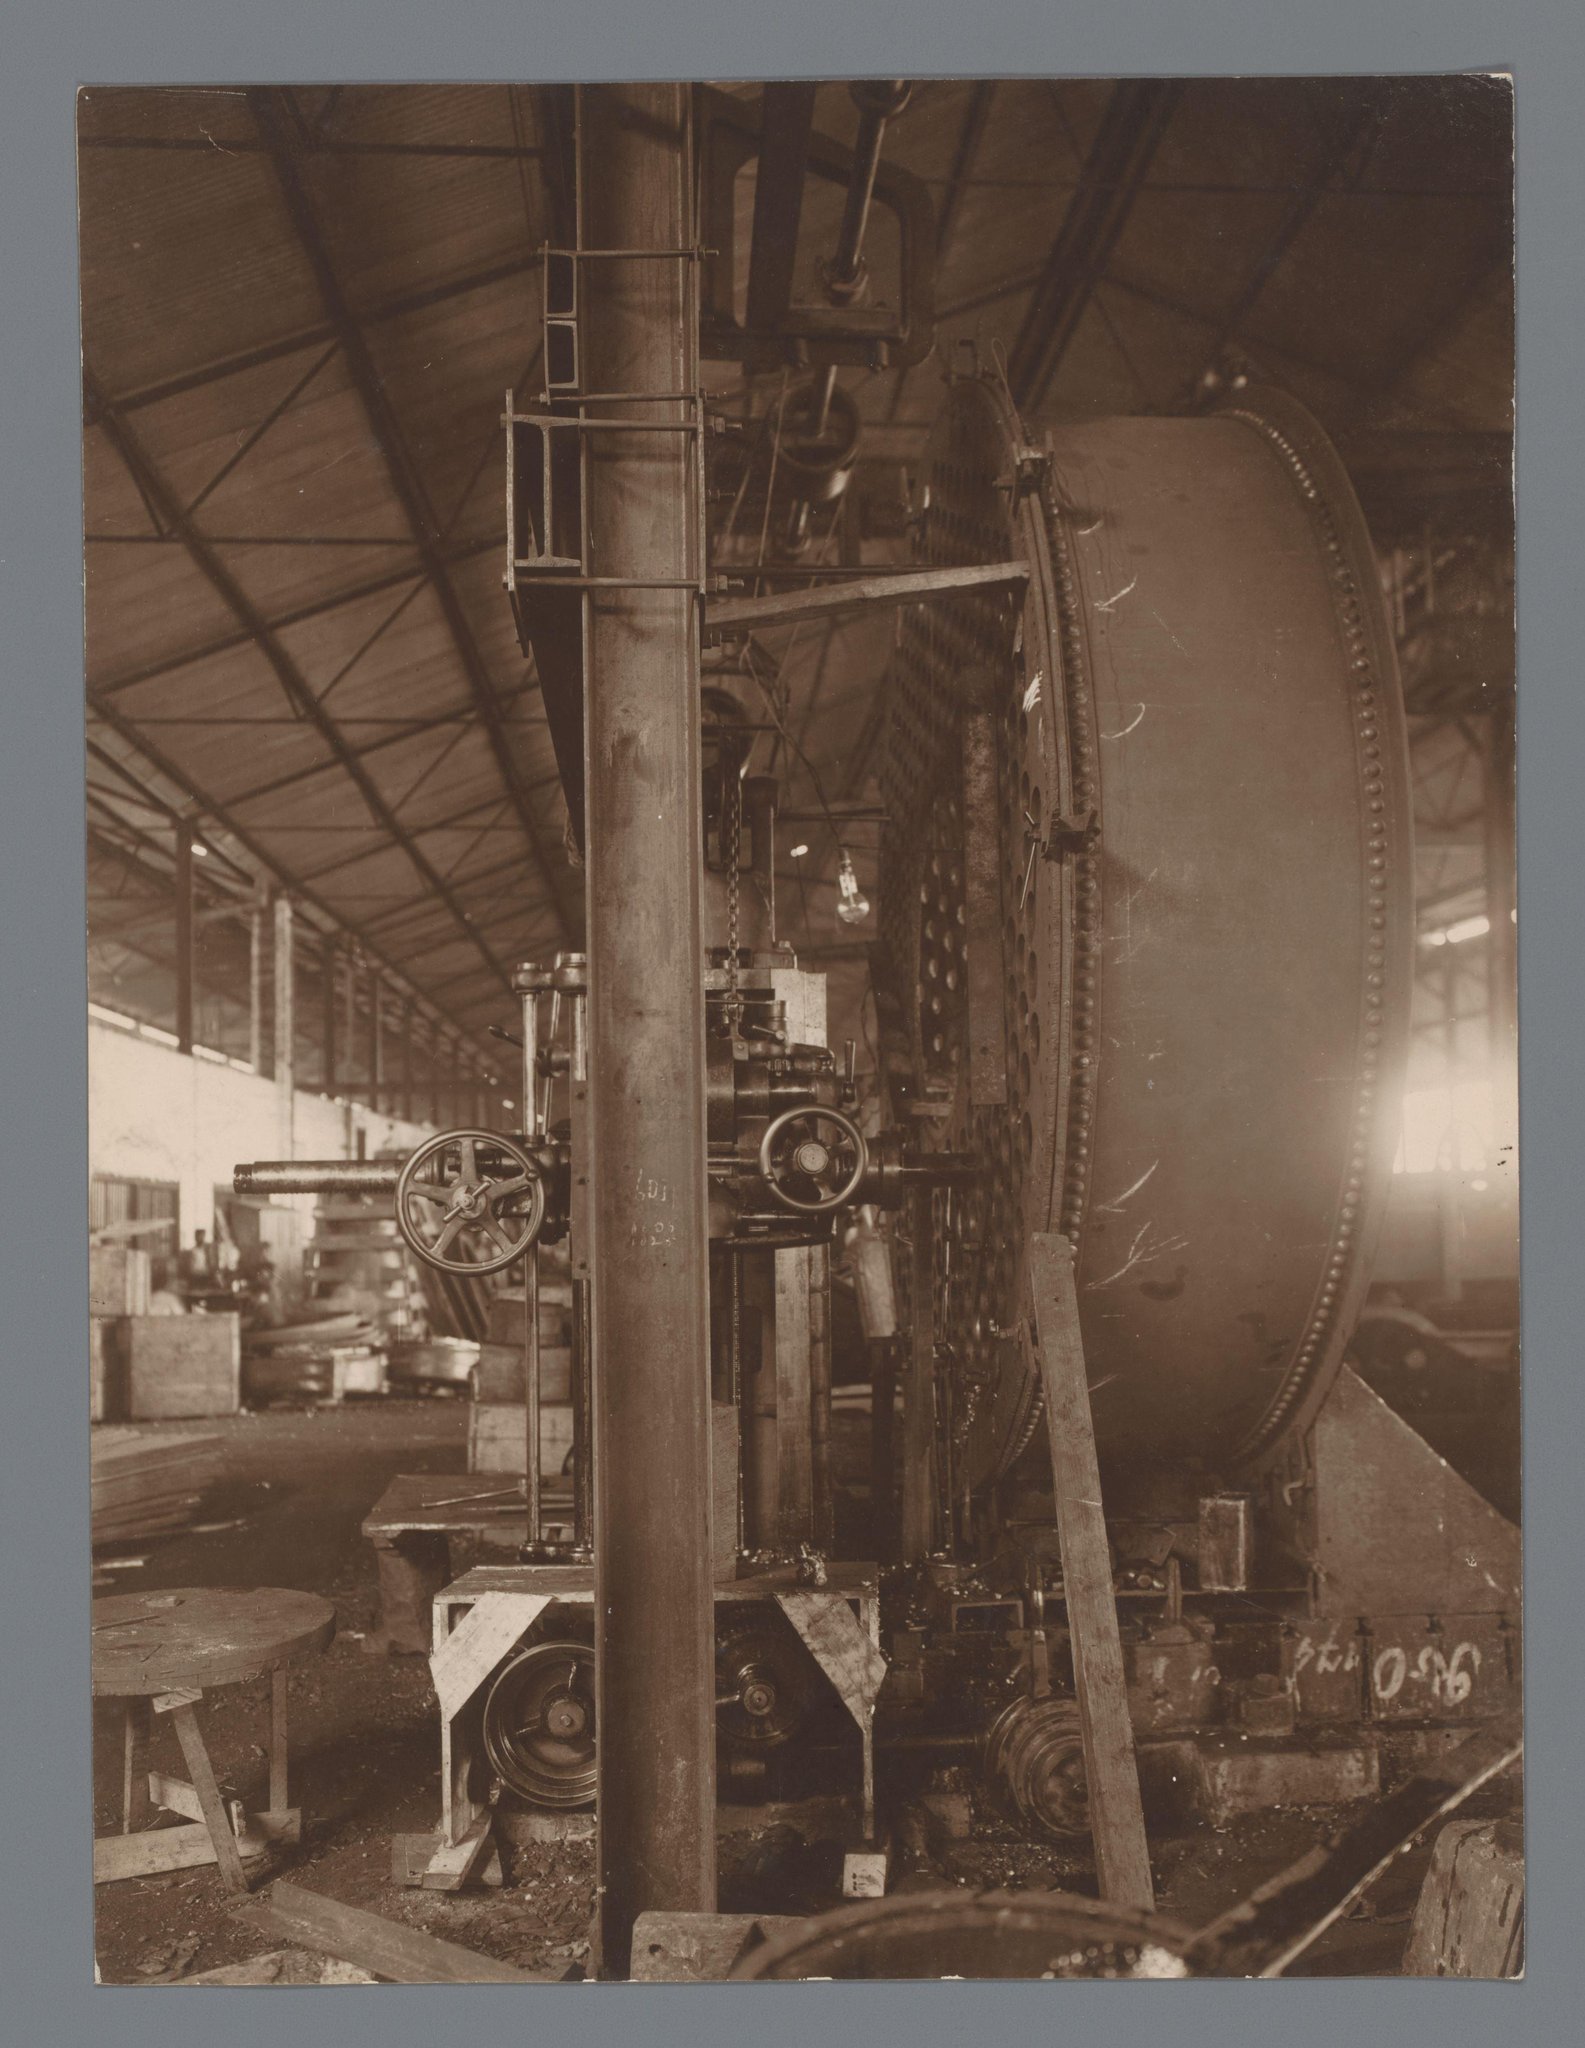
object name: photograph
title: Product Photos N.V. Machinefabriek Braat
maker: Anonymous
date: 1919-1921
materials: photographic support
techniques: gelatin silver print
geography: surabaya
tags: colonial system, factory-interior, machine shop, machines; parts of machines; tools and appliances, java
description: These photographs feature machines manufactured by Machinefabriek Braat in Surabaya for colonial enterprises in the Dutch East Indies (now Indonesia). These machines were primarily intended for large sugar mills. A clearly displayed text board provides an explanation of the machines and Indonesian factory workers are included to give a sense of scale for their size.